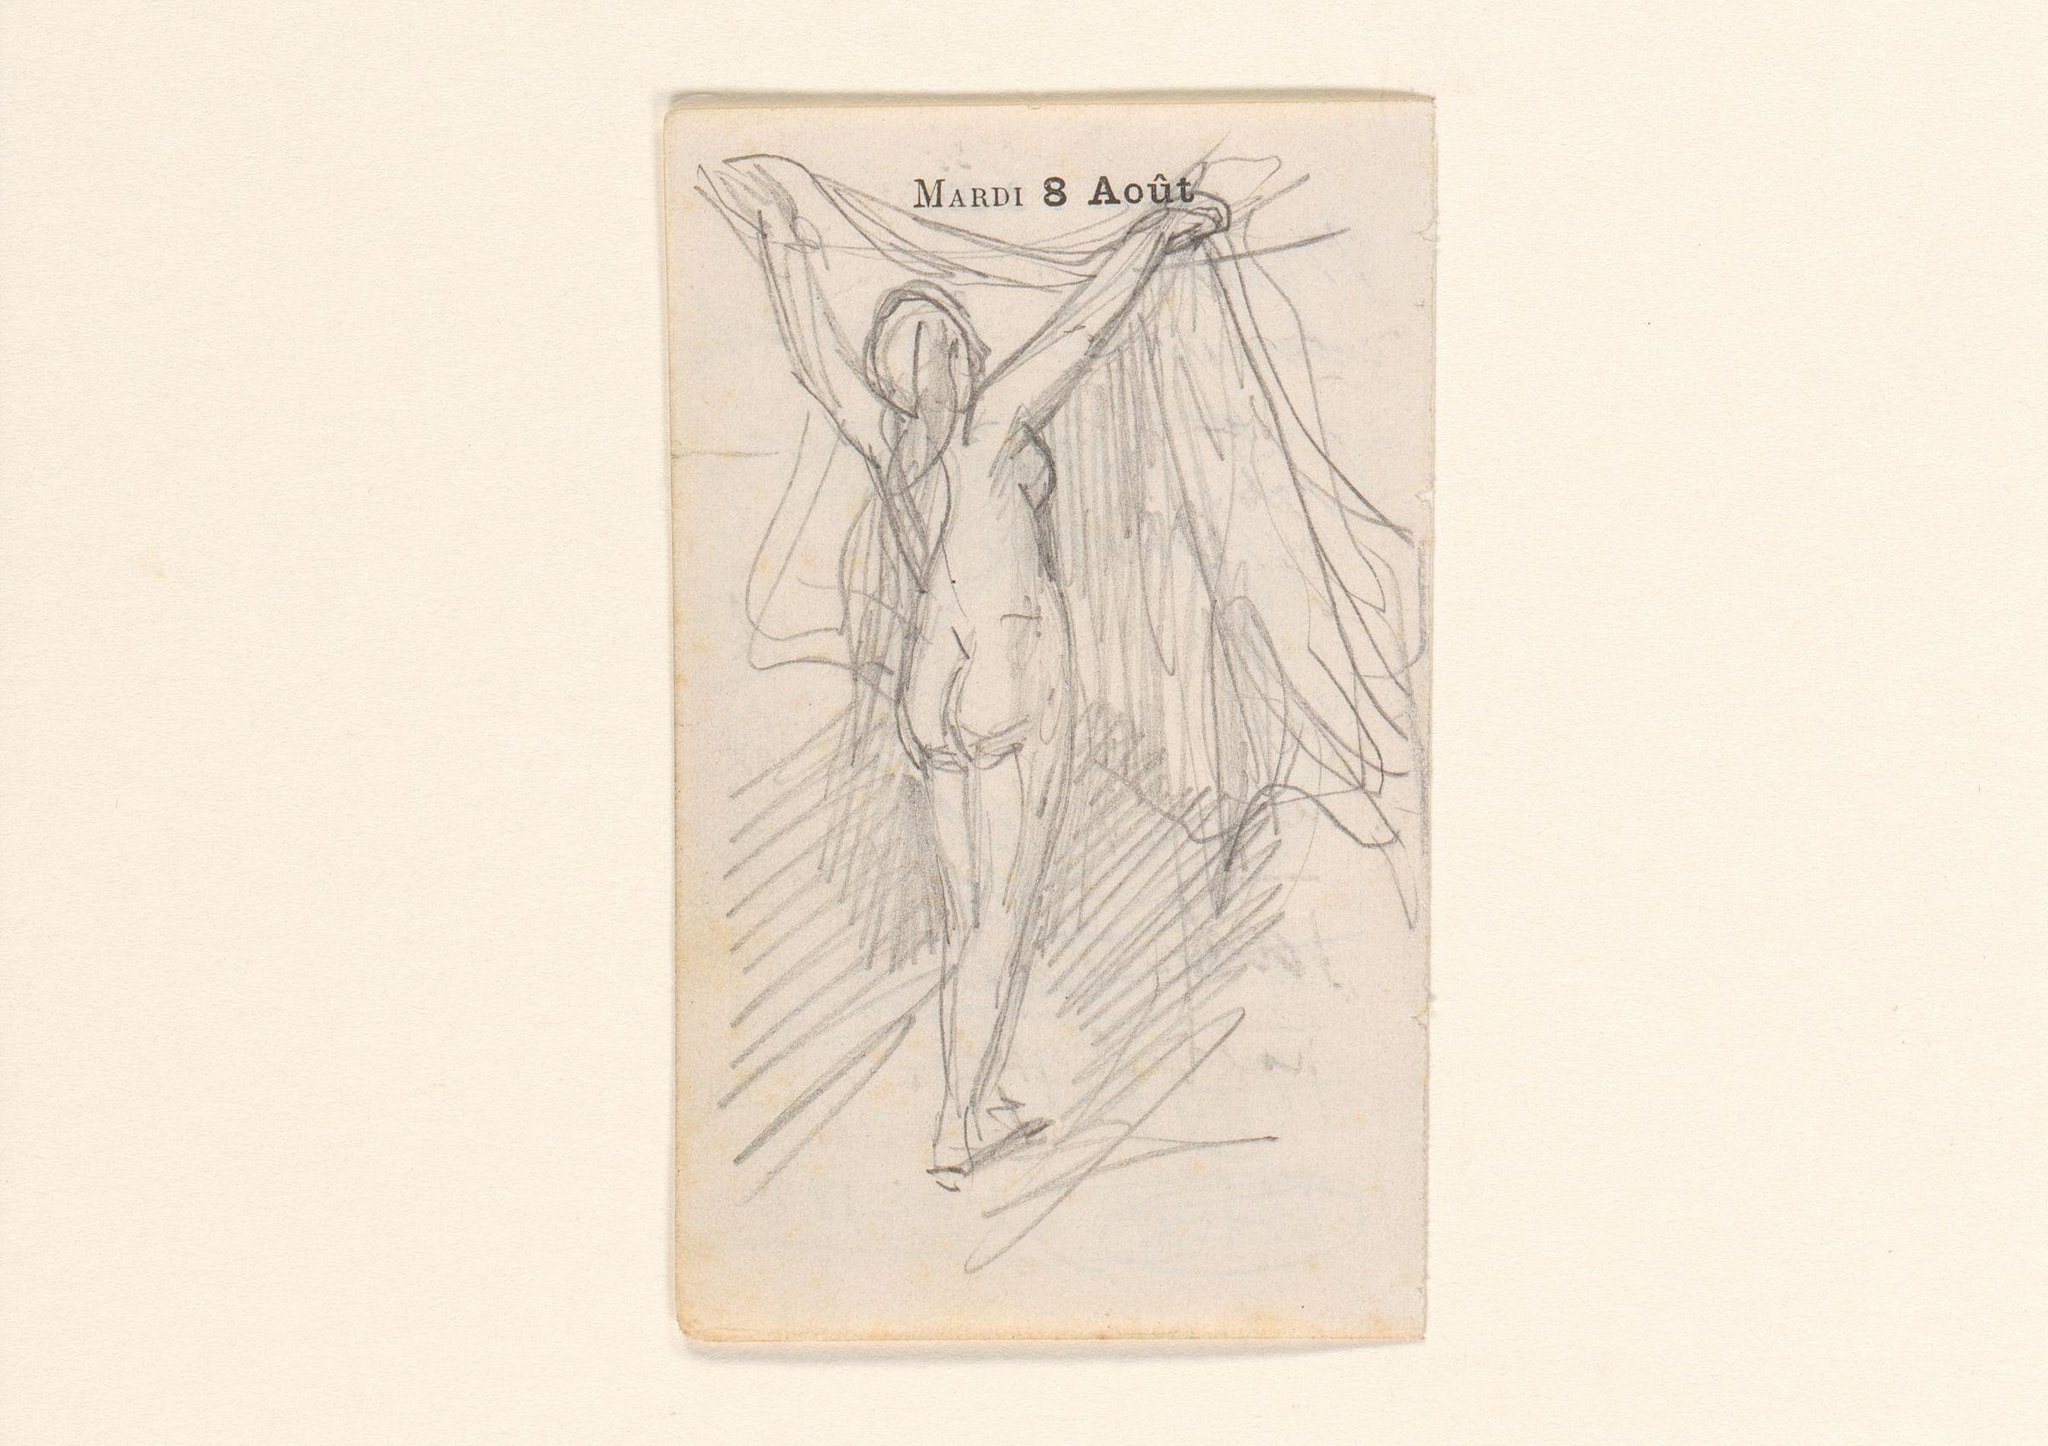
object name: drawing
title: Studie van een naakte vrouw met een doek in de handen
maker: august allebé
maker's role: draughtsman, print maker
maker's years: 1838-1927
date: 1848-1927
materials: paper, pencil